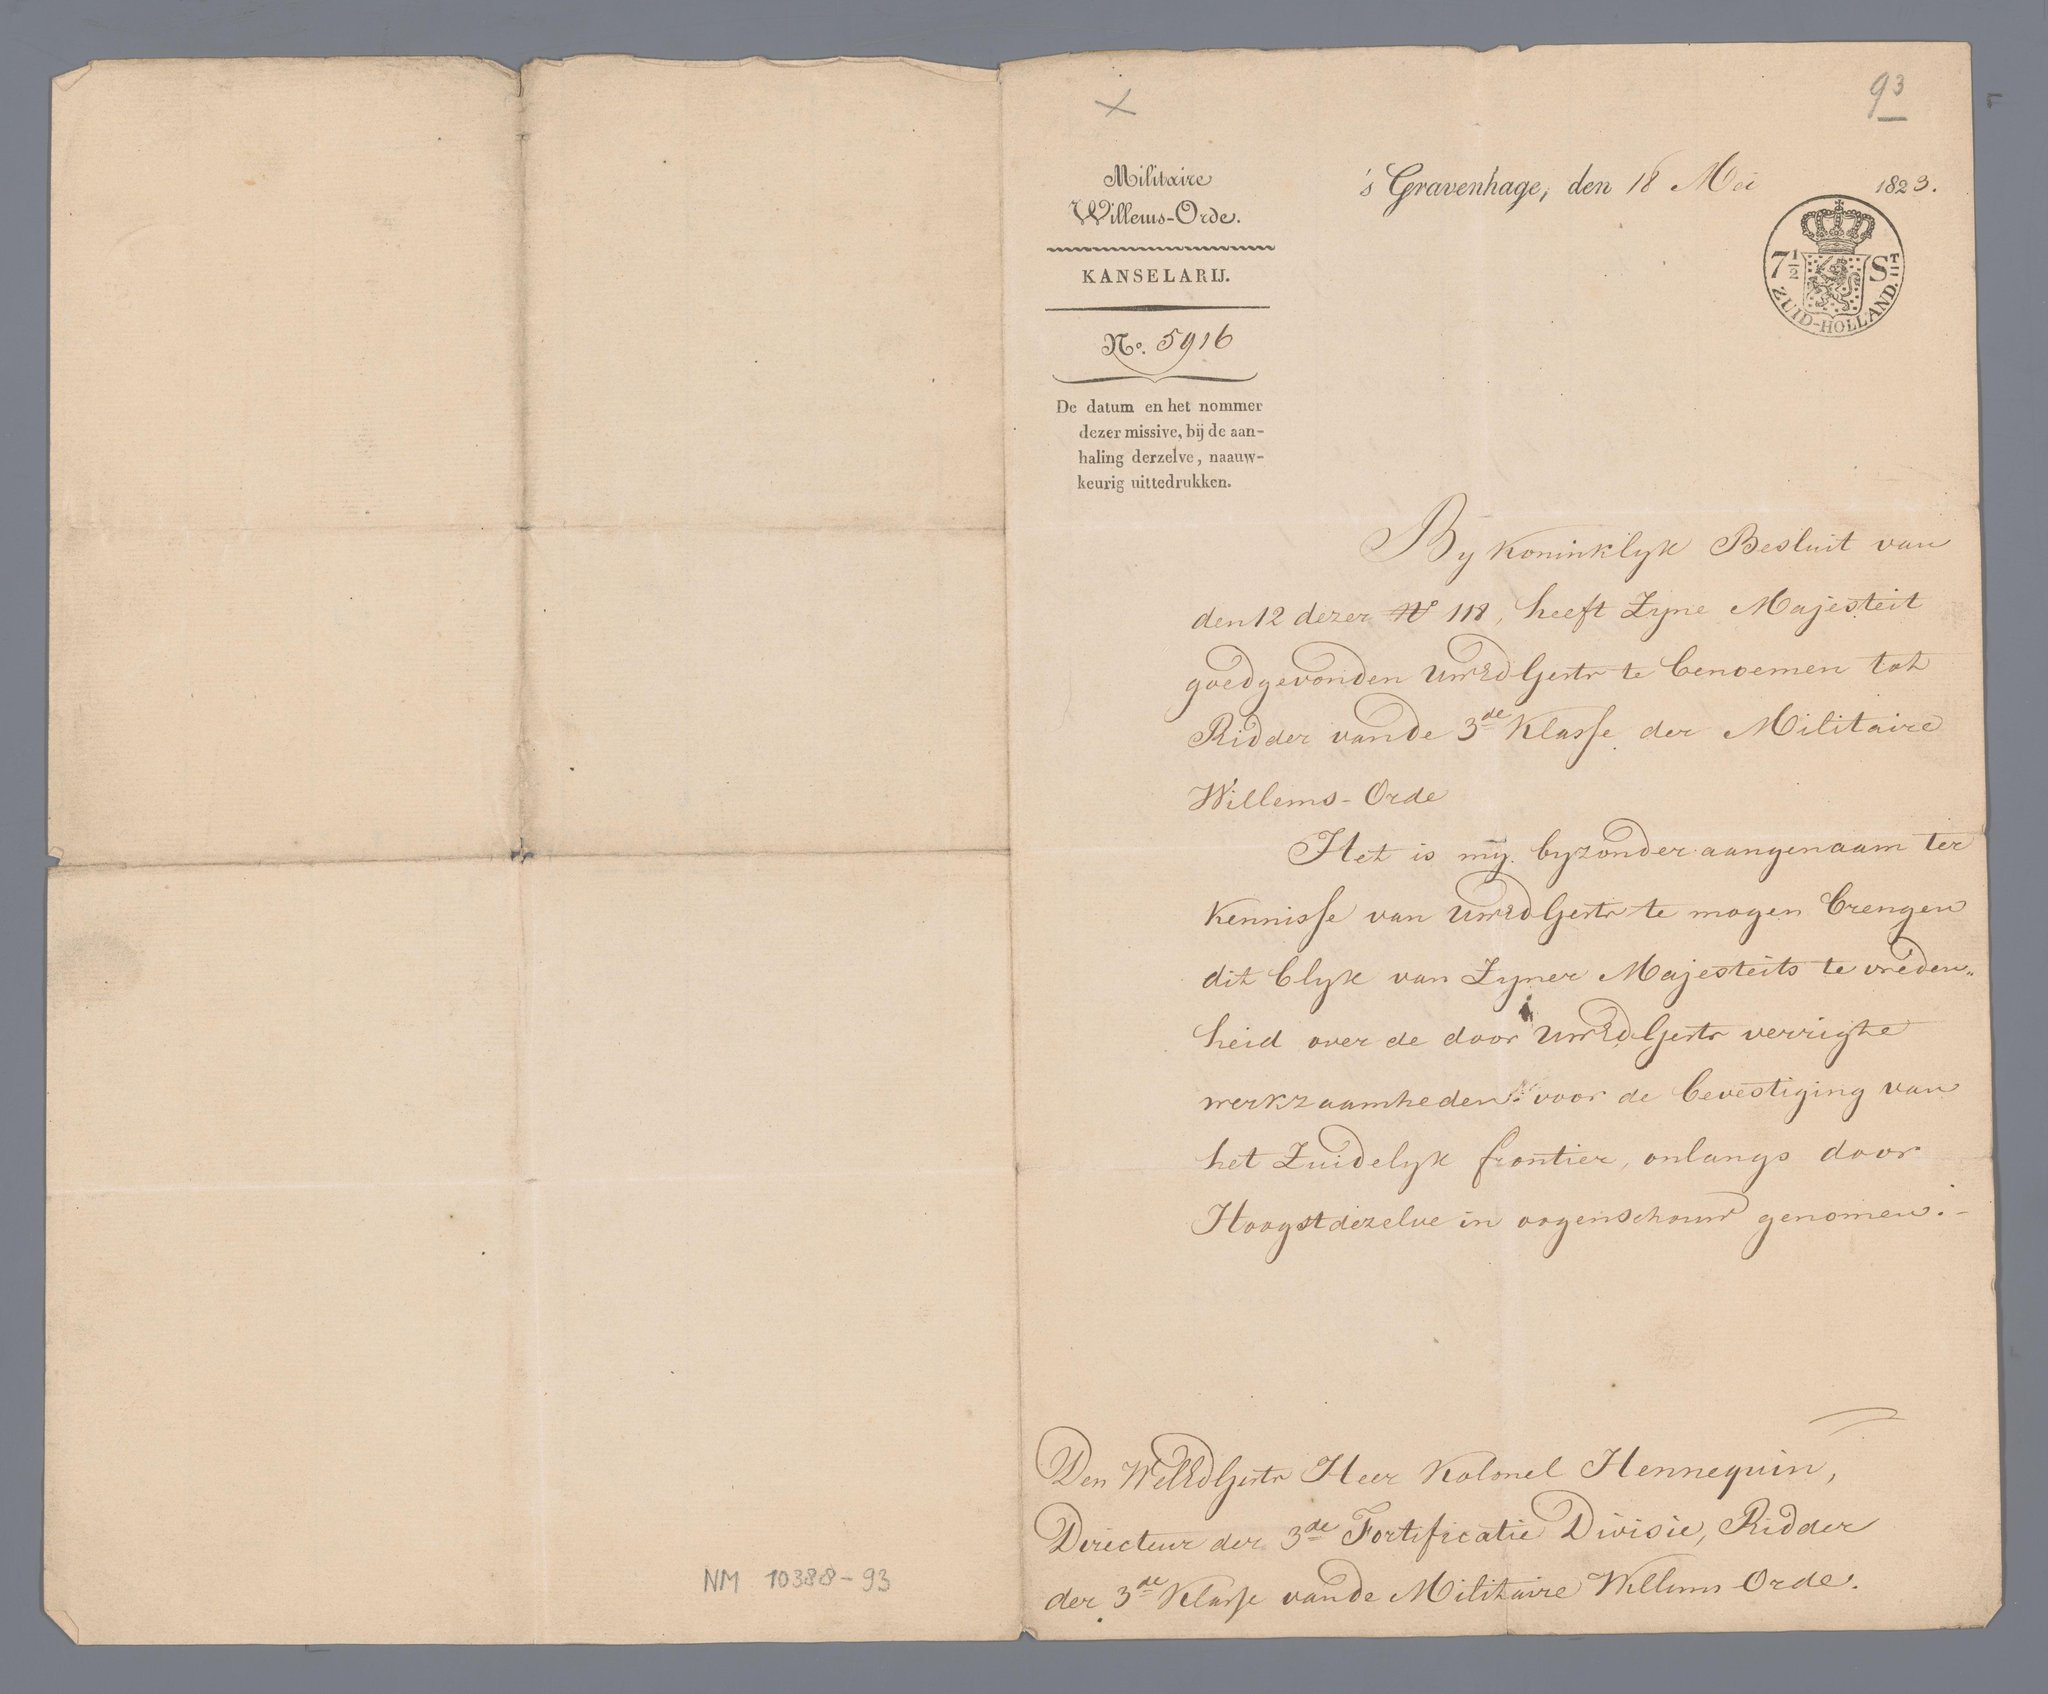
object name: document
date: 1823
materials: ink, paper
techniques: printing, writing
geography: the hague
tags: pieter hennequin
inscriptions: date